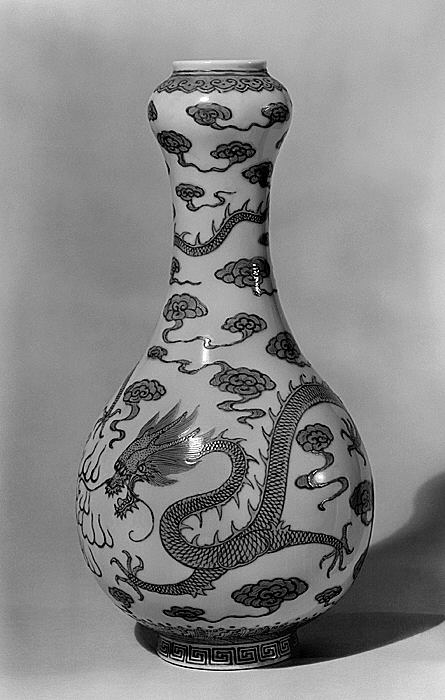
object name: vase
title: Vase with dragons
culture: chinese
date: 1901-1950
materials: enamel, porcelain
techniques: overglaze, painting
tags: dragons